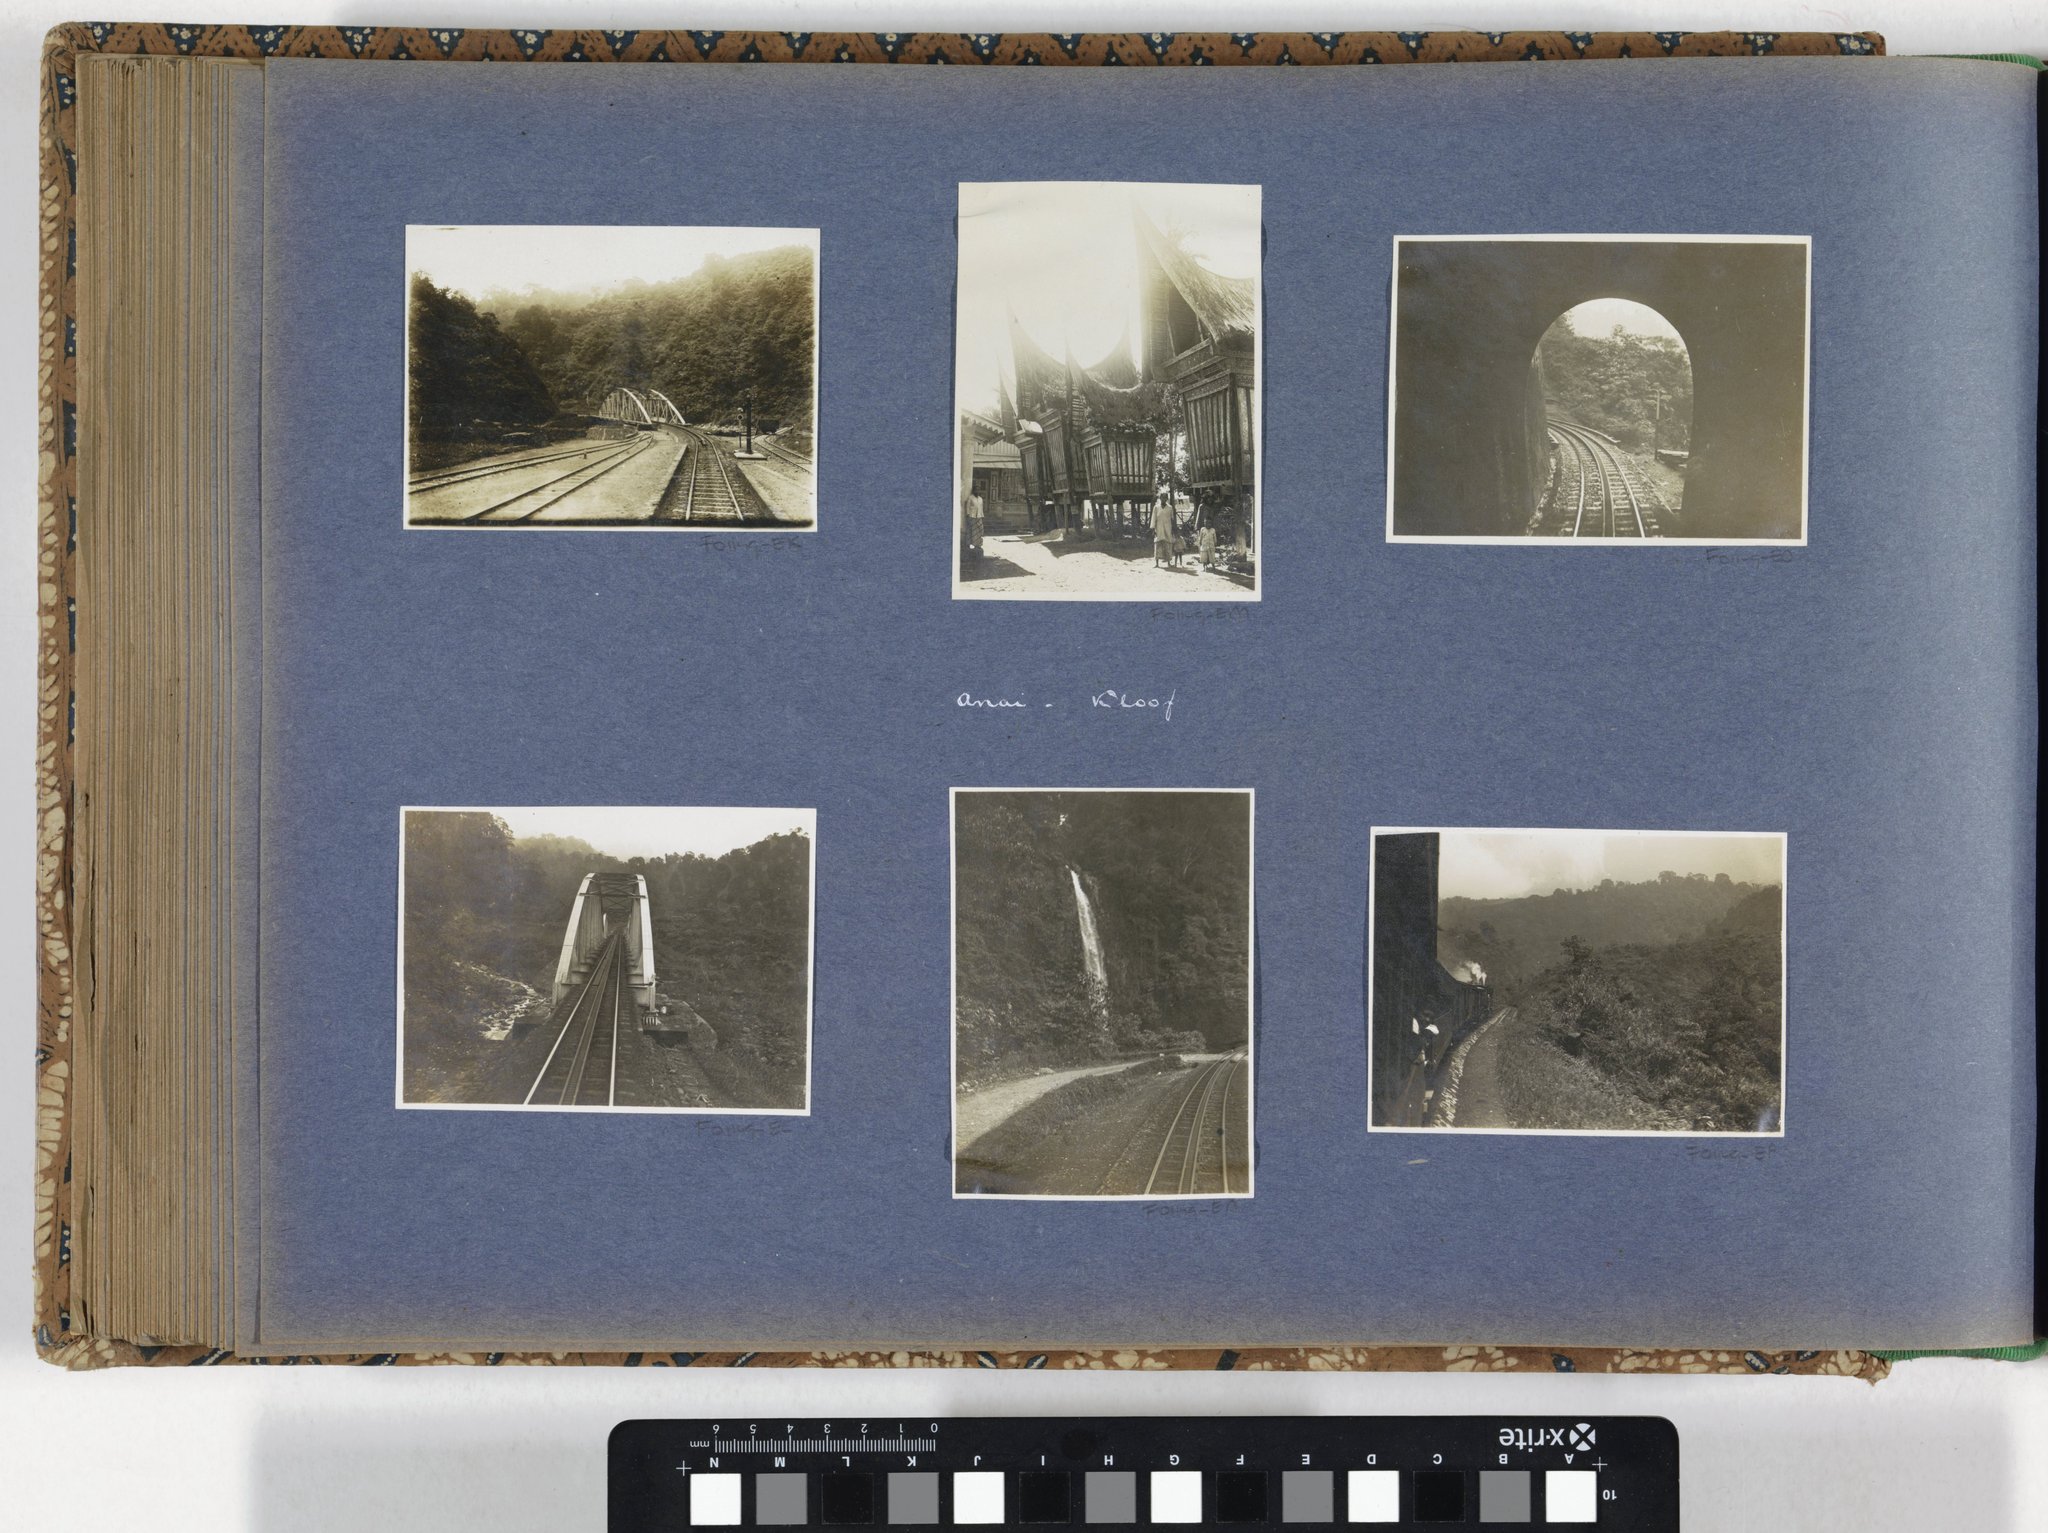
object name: album leaf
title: Spoorbrug in de Anaikloof op Sumatra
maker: Anonymous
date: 1900-1920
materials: paper, photographic support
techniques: gelatin silver print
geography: sumatra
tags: landscape with bridge, viaduct or aqueduct, railway, train, sumatra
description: Onderdeel van reisalbum met foto's van bedrijvigheid en bezienswaardigheden op Sumatra en Java en van de reis naar en van Nederlands-Indië.